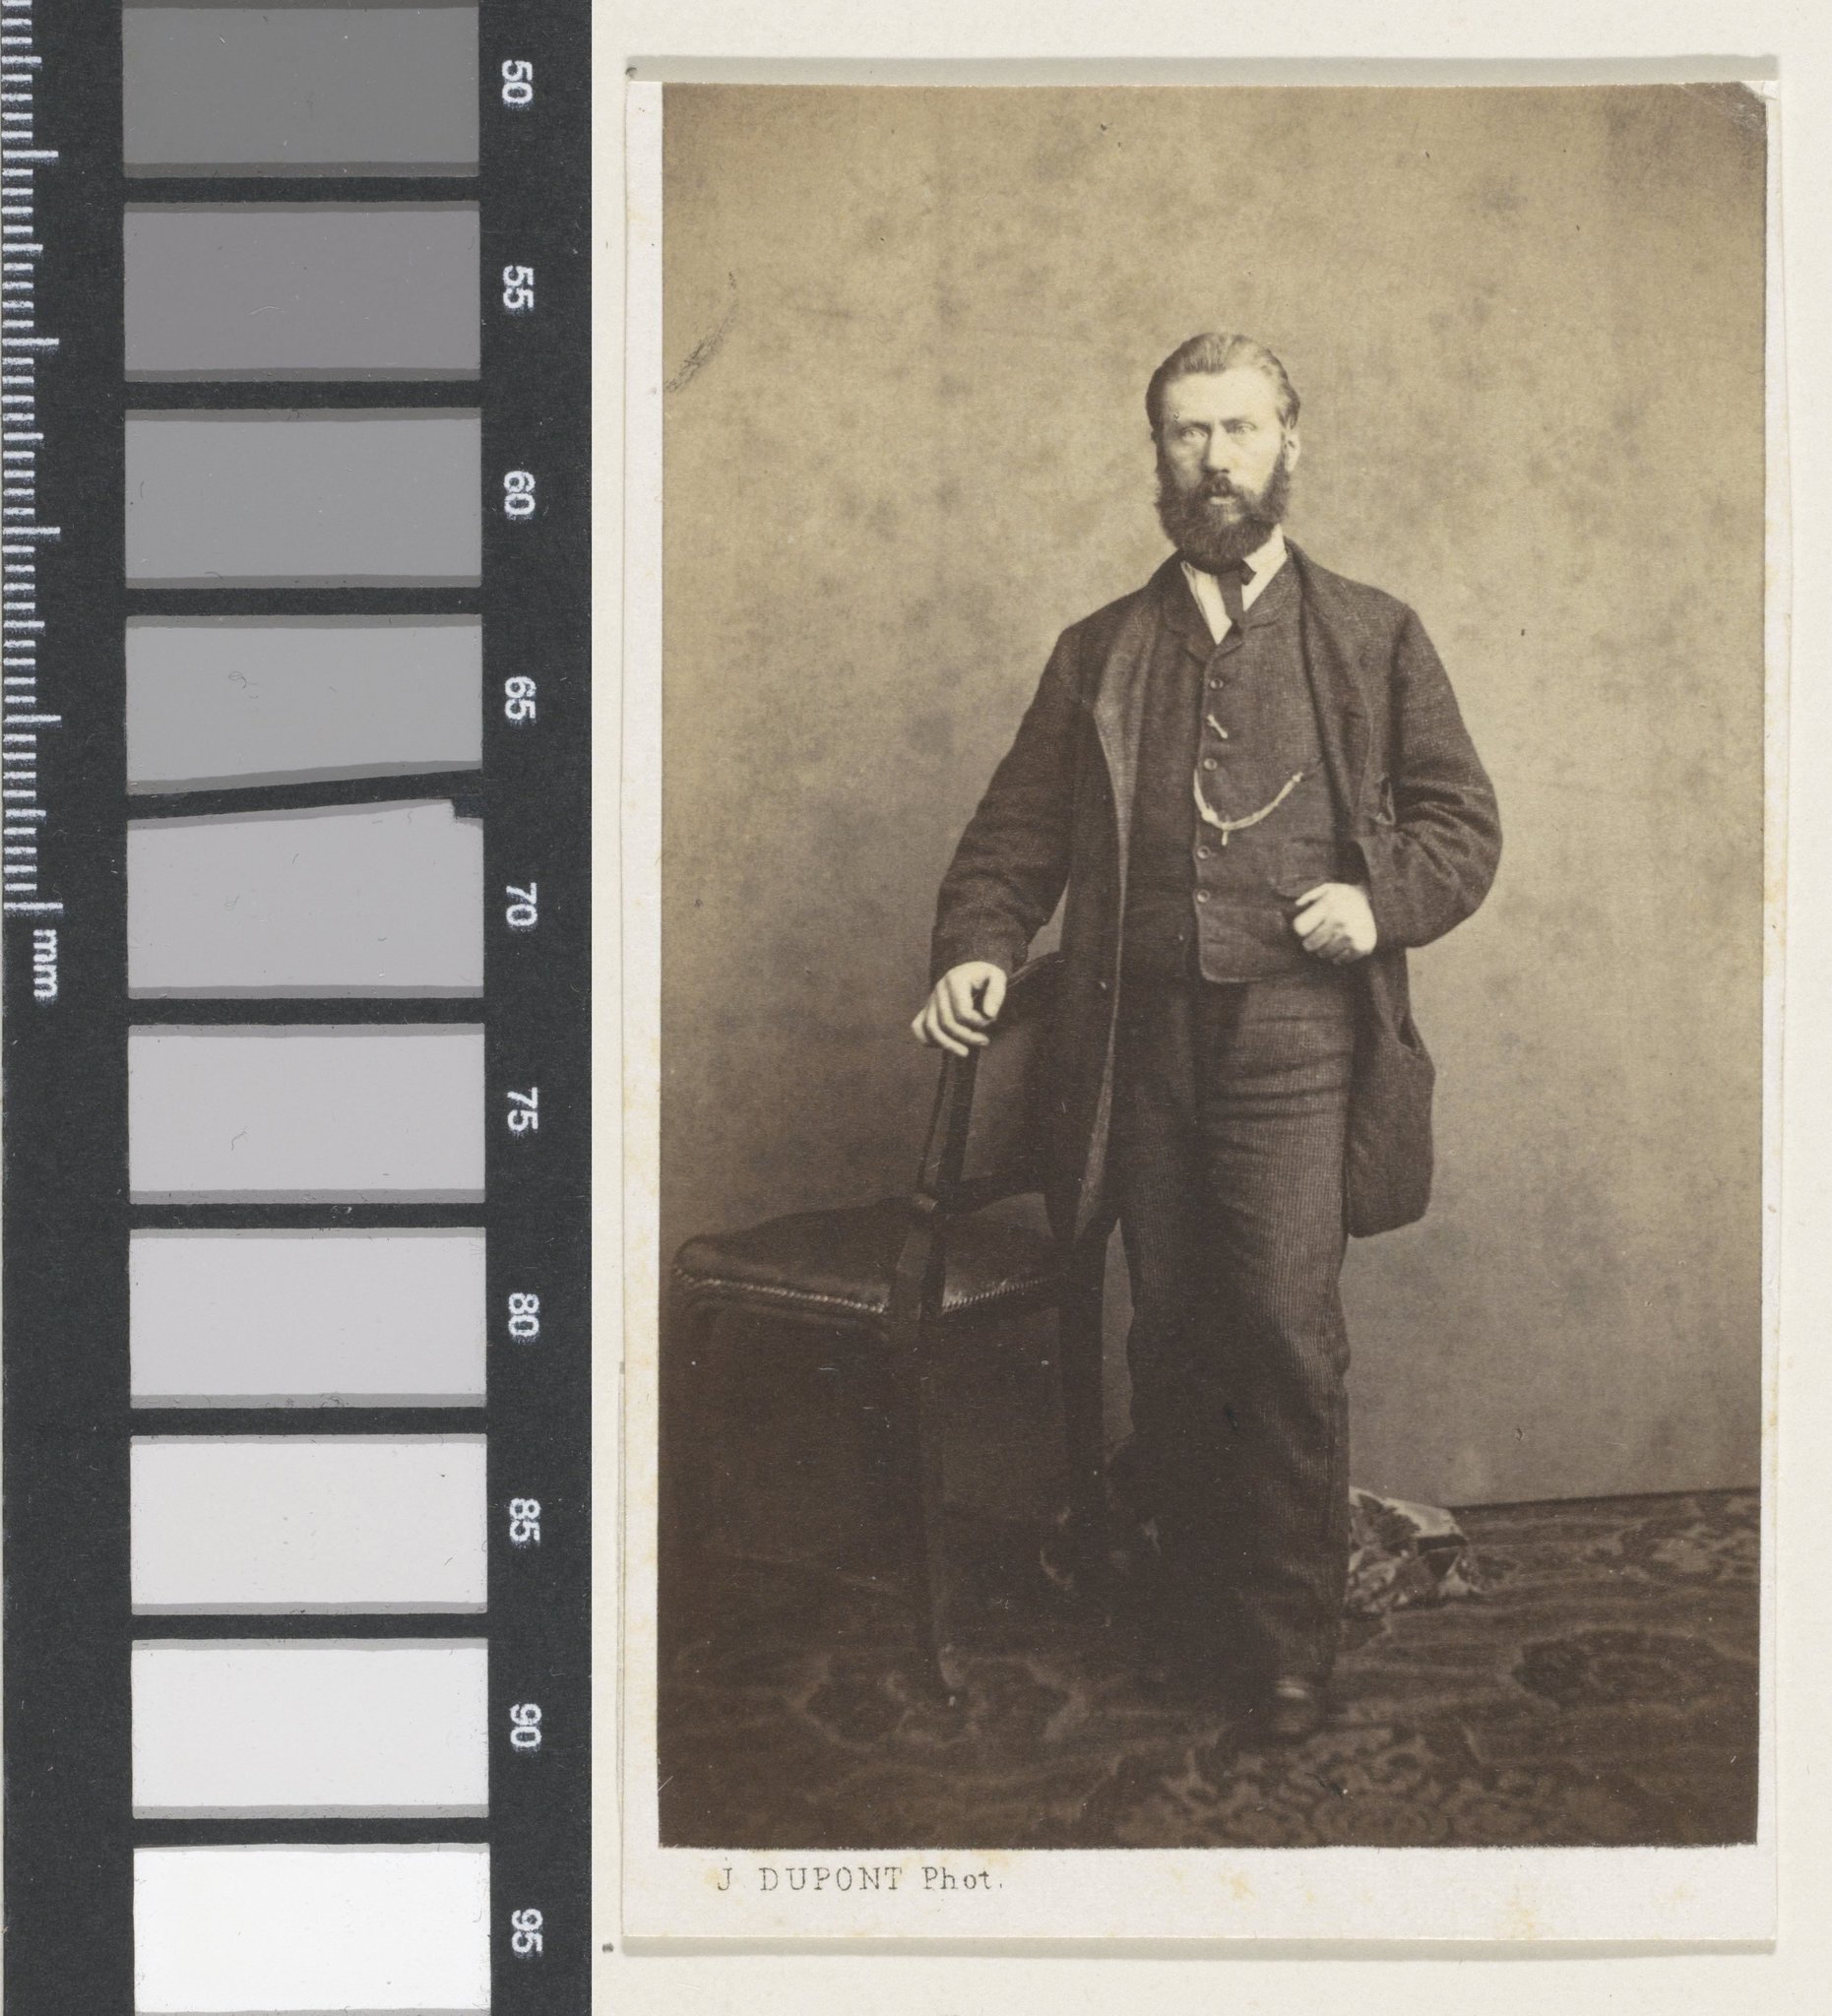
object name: photograph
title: Portret van de schilder Adolf Alexander Dillens, ten voeten uit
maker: joseph dupont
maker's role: fotograaf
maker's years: 1818-1901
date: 1861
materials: cardboard, paper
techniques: albumen print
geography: antwerp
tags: ghent, brussels, painter, print maker, draughtsman, adolphe alexandre dillens, historical persons, portrait, self-portrait of painter, portrait, self-portrait of artist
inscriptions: inscription: ‘ETABLISSEMENT PHOTOGRAPHIQUE/ de/ J. DUPONT/ Place de Meir 32/ ANVERS/ Maison fondée en 1853’